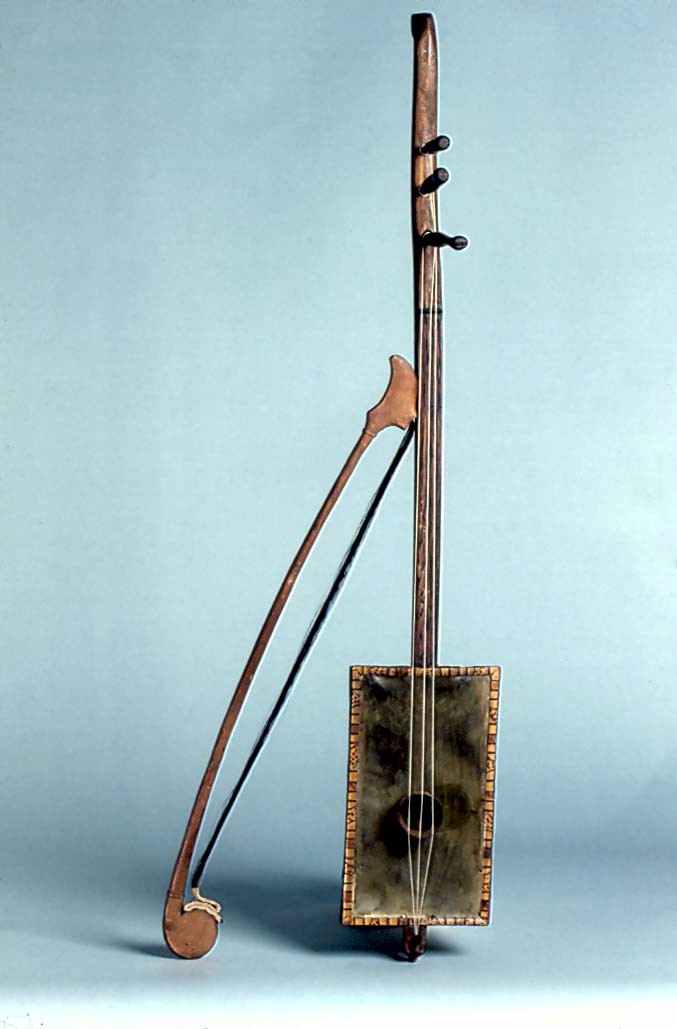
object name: tarawangsa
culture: javanese, sunda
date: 1801-1900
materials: parchment, silk, wood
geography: indonesia